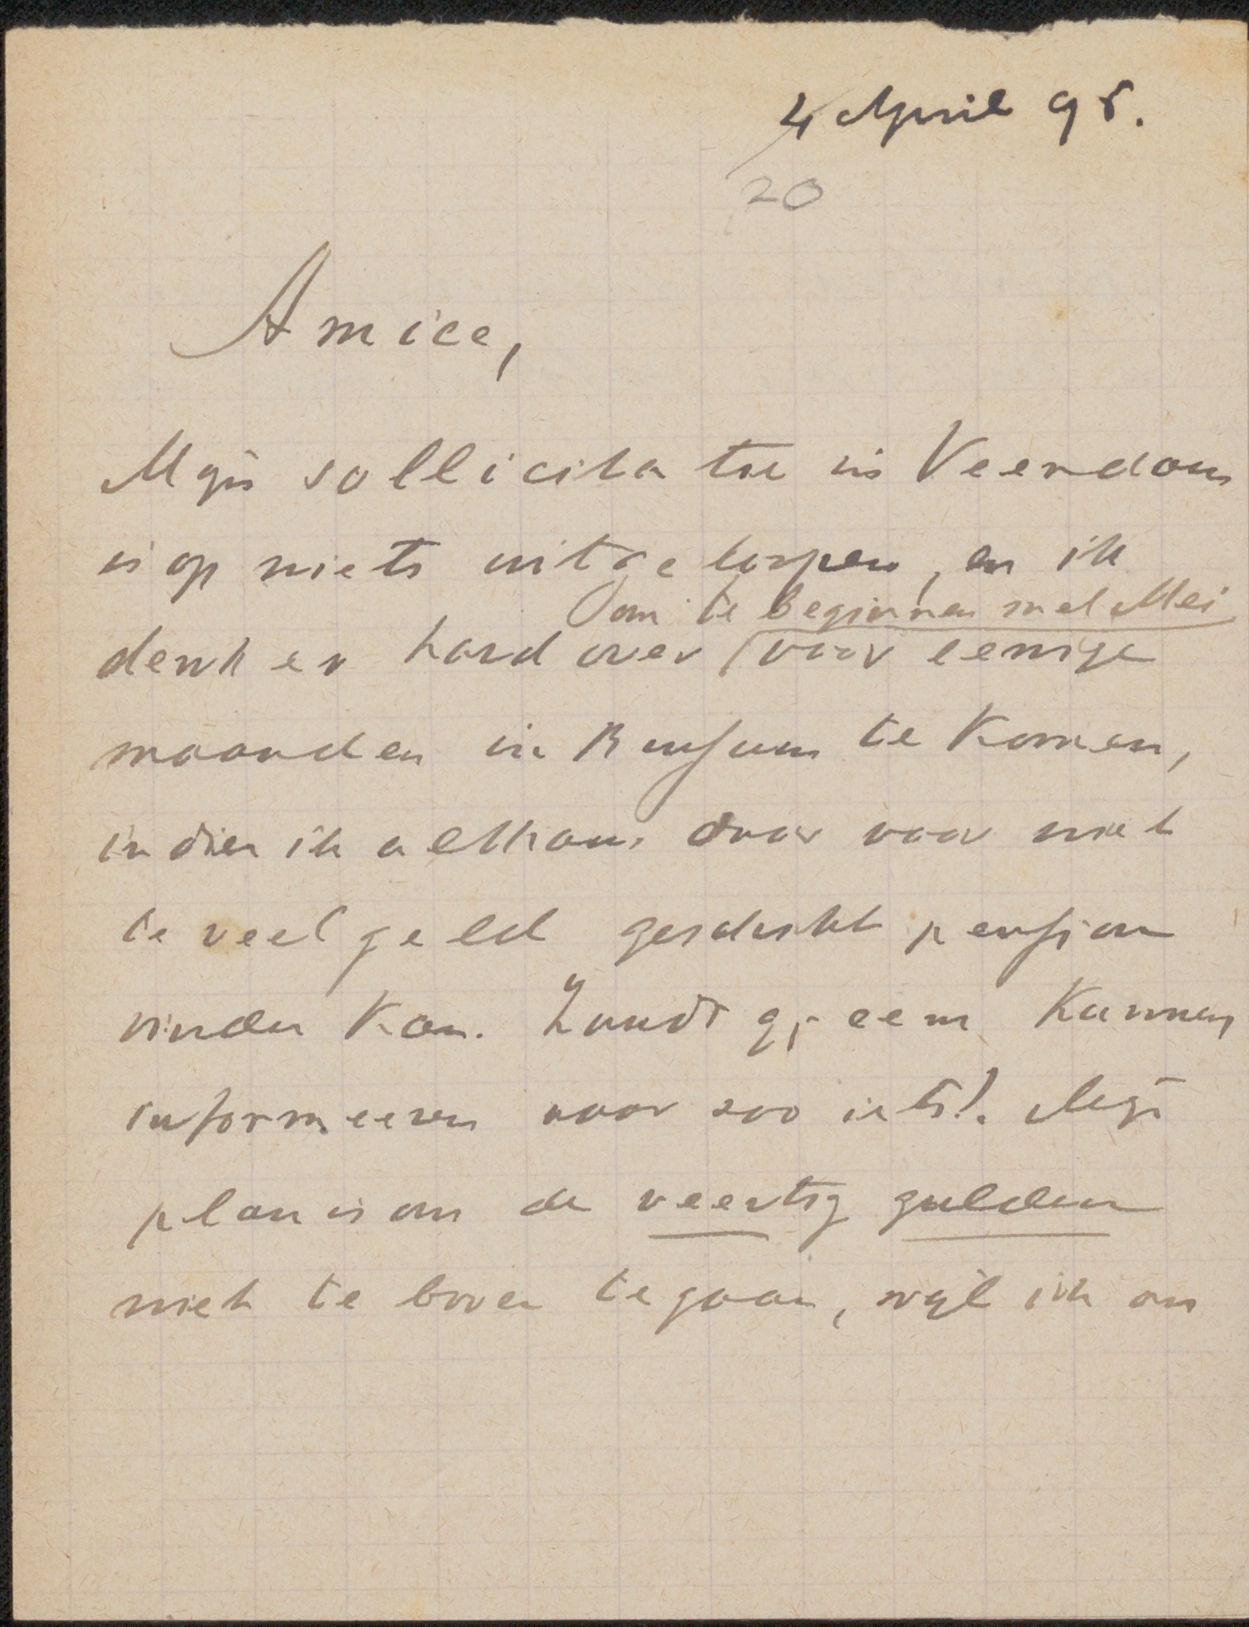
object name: letter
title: Brief aan Jan Veth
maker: chap van deventer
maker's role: kunstcriticus, scheikundige, schrijver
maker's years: 1860-1931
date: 1895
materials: ink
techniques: pen, writing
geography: amsterdam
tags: dordrecht, amsterdam, painter, print maker, draughtsman, designer, jan veth, money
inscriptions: collector's mark: ‘RPK’